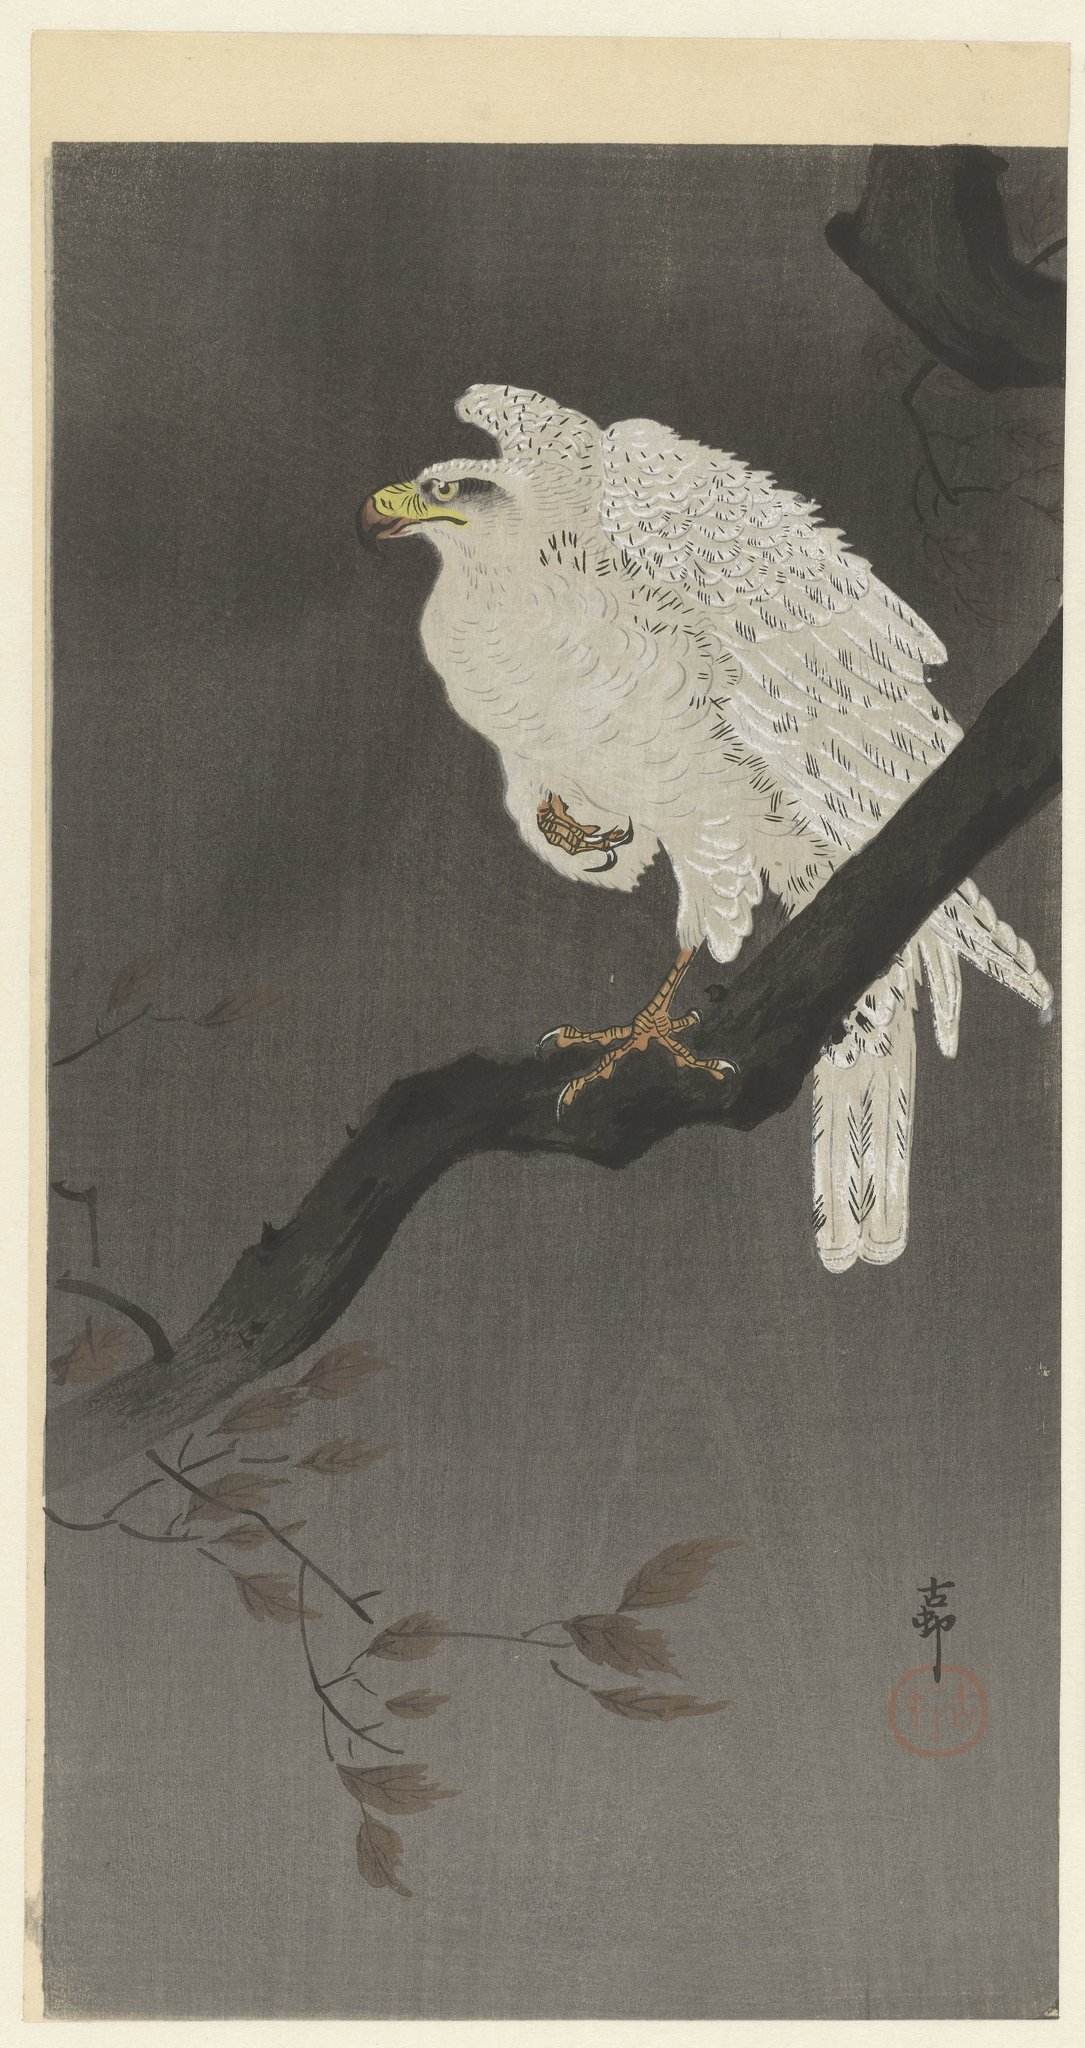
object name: print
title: Sneeuwarend op een boomtak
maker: ohara koson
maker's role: print maker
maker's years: 1877-1945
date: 1910-1930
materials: paper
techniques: woodcut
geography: japan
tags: predatory birds: eagle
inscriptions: collector's mark: Lugt 2228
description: Witte roofvogel, naar links, met één poot ingetrokken op boomtak, bij nacht.